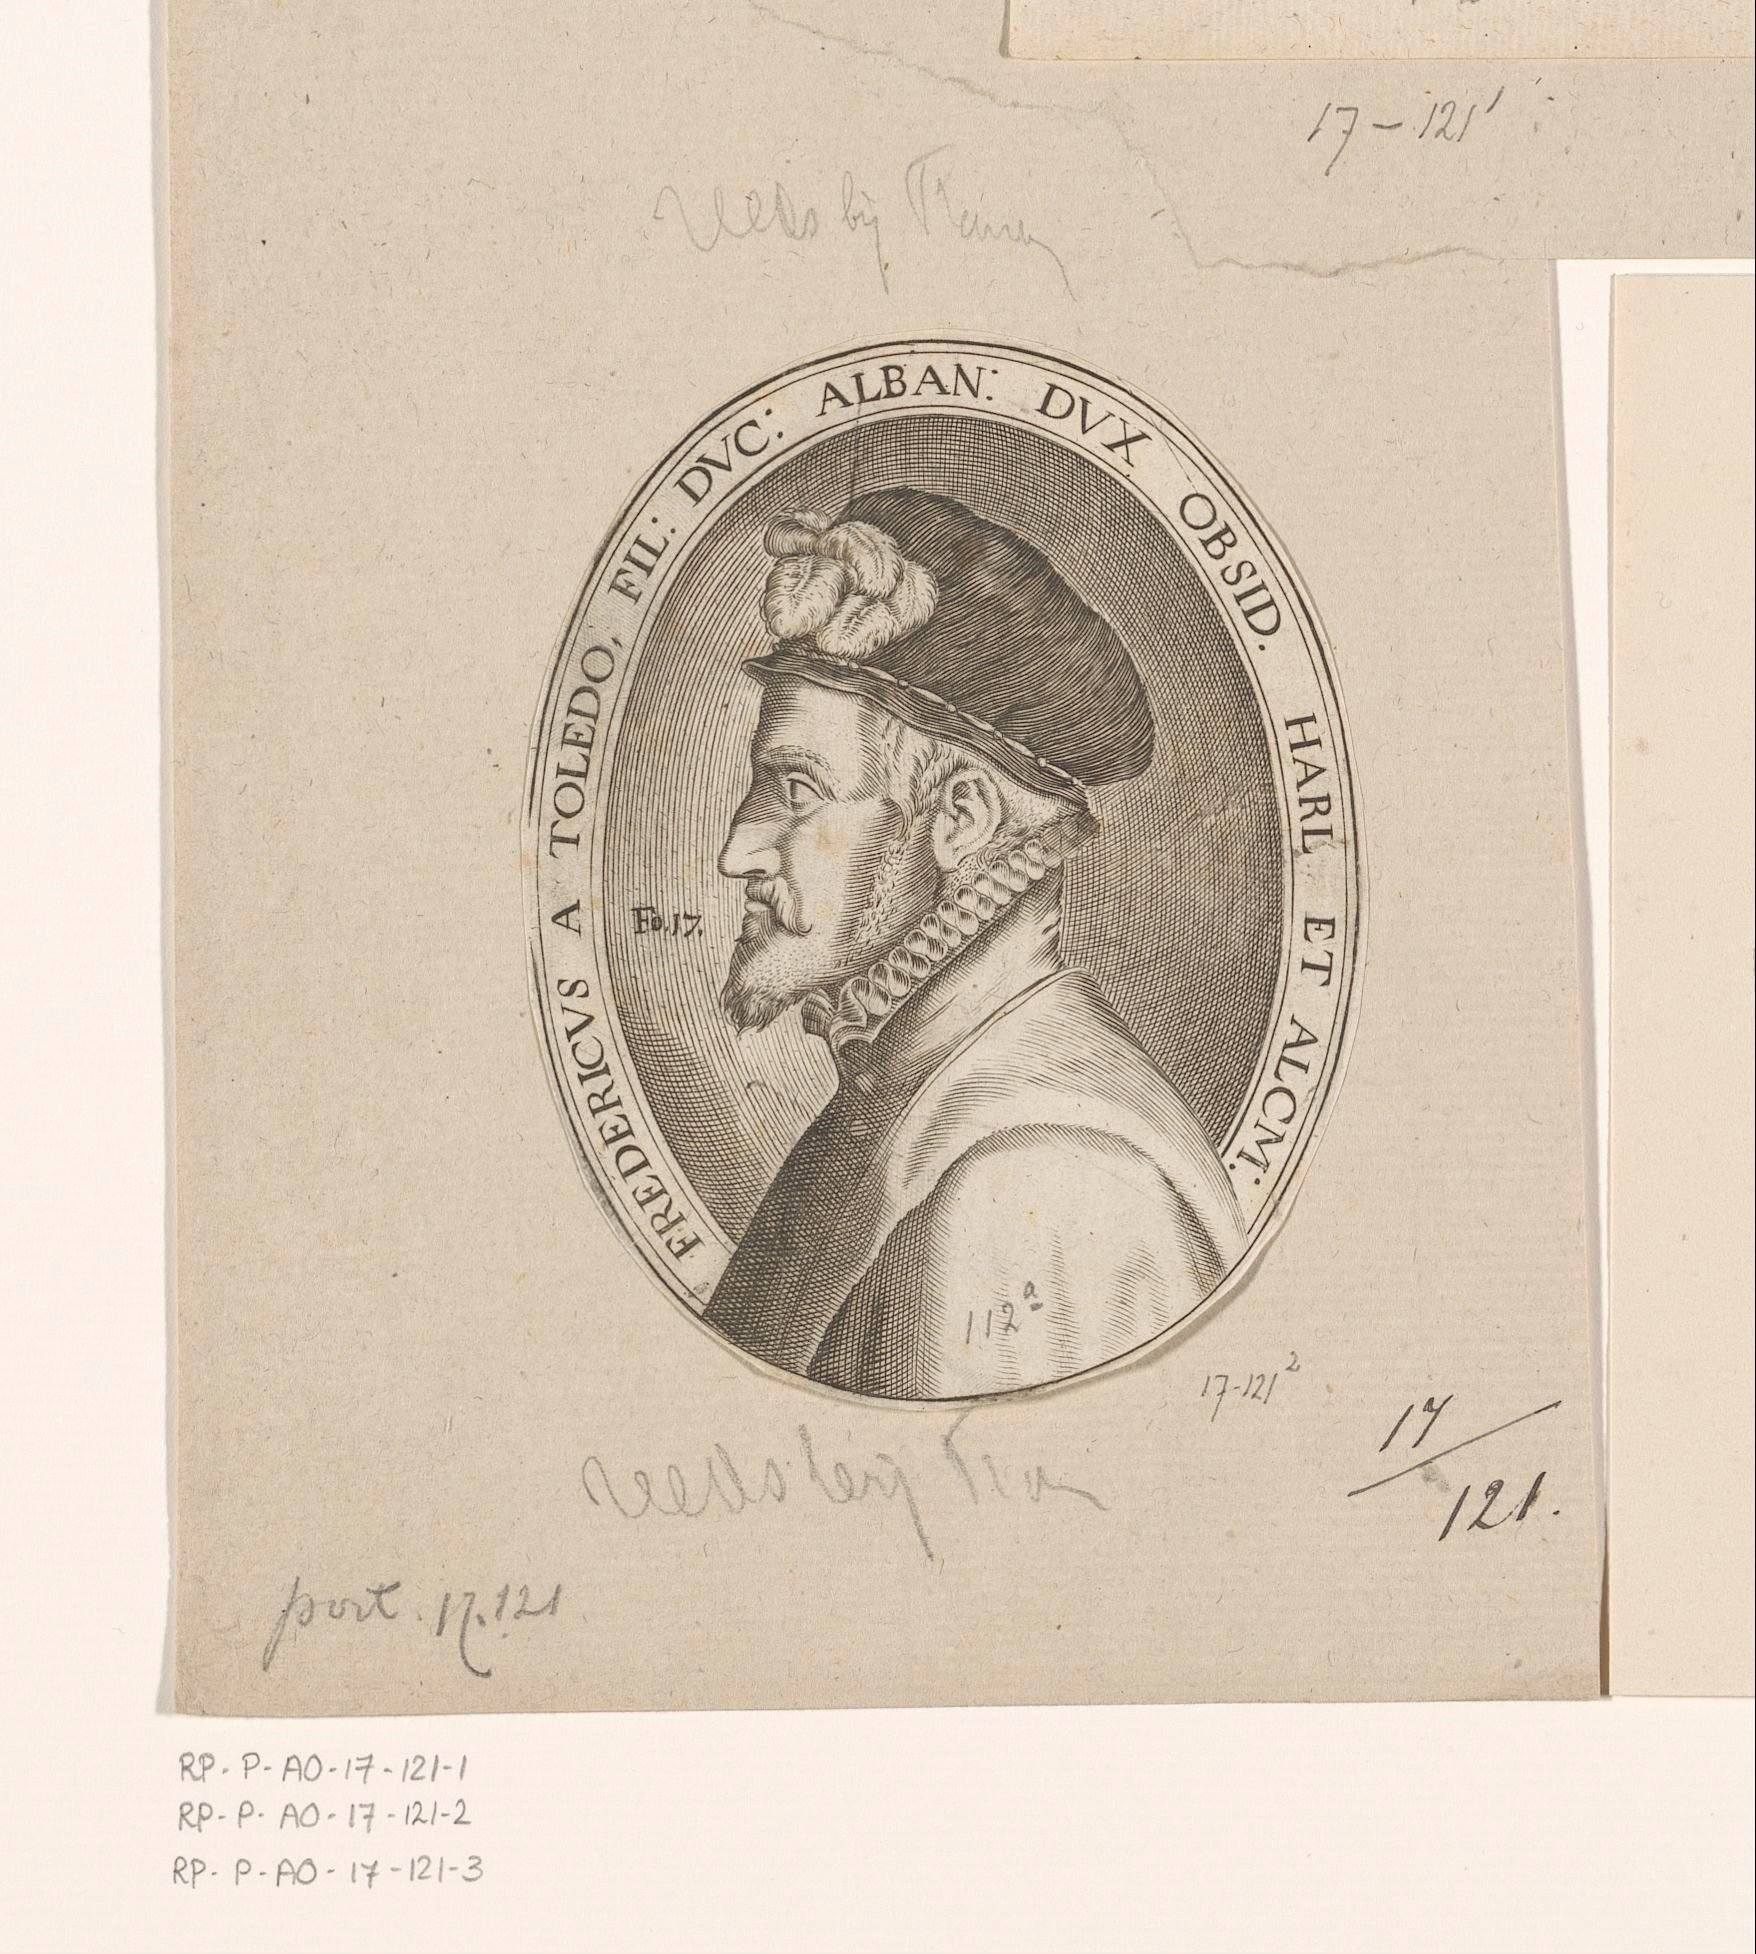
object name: print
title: Portret van Fadrique Álvarez de Toledo hertog van Alva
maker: Anonymous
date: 1650-1753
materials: paper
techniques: engraving, etching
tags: lissabon, bevelhebber, fadrique alvarez de toledo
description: Portret van Fadrique Álvarez de Toledo hertog van Alva. Links gemerkt: Fo. 17.